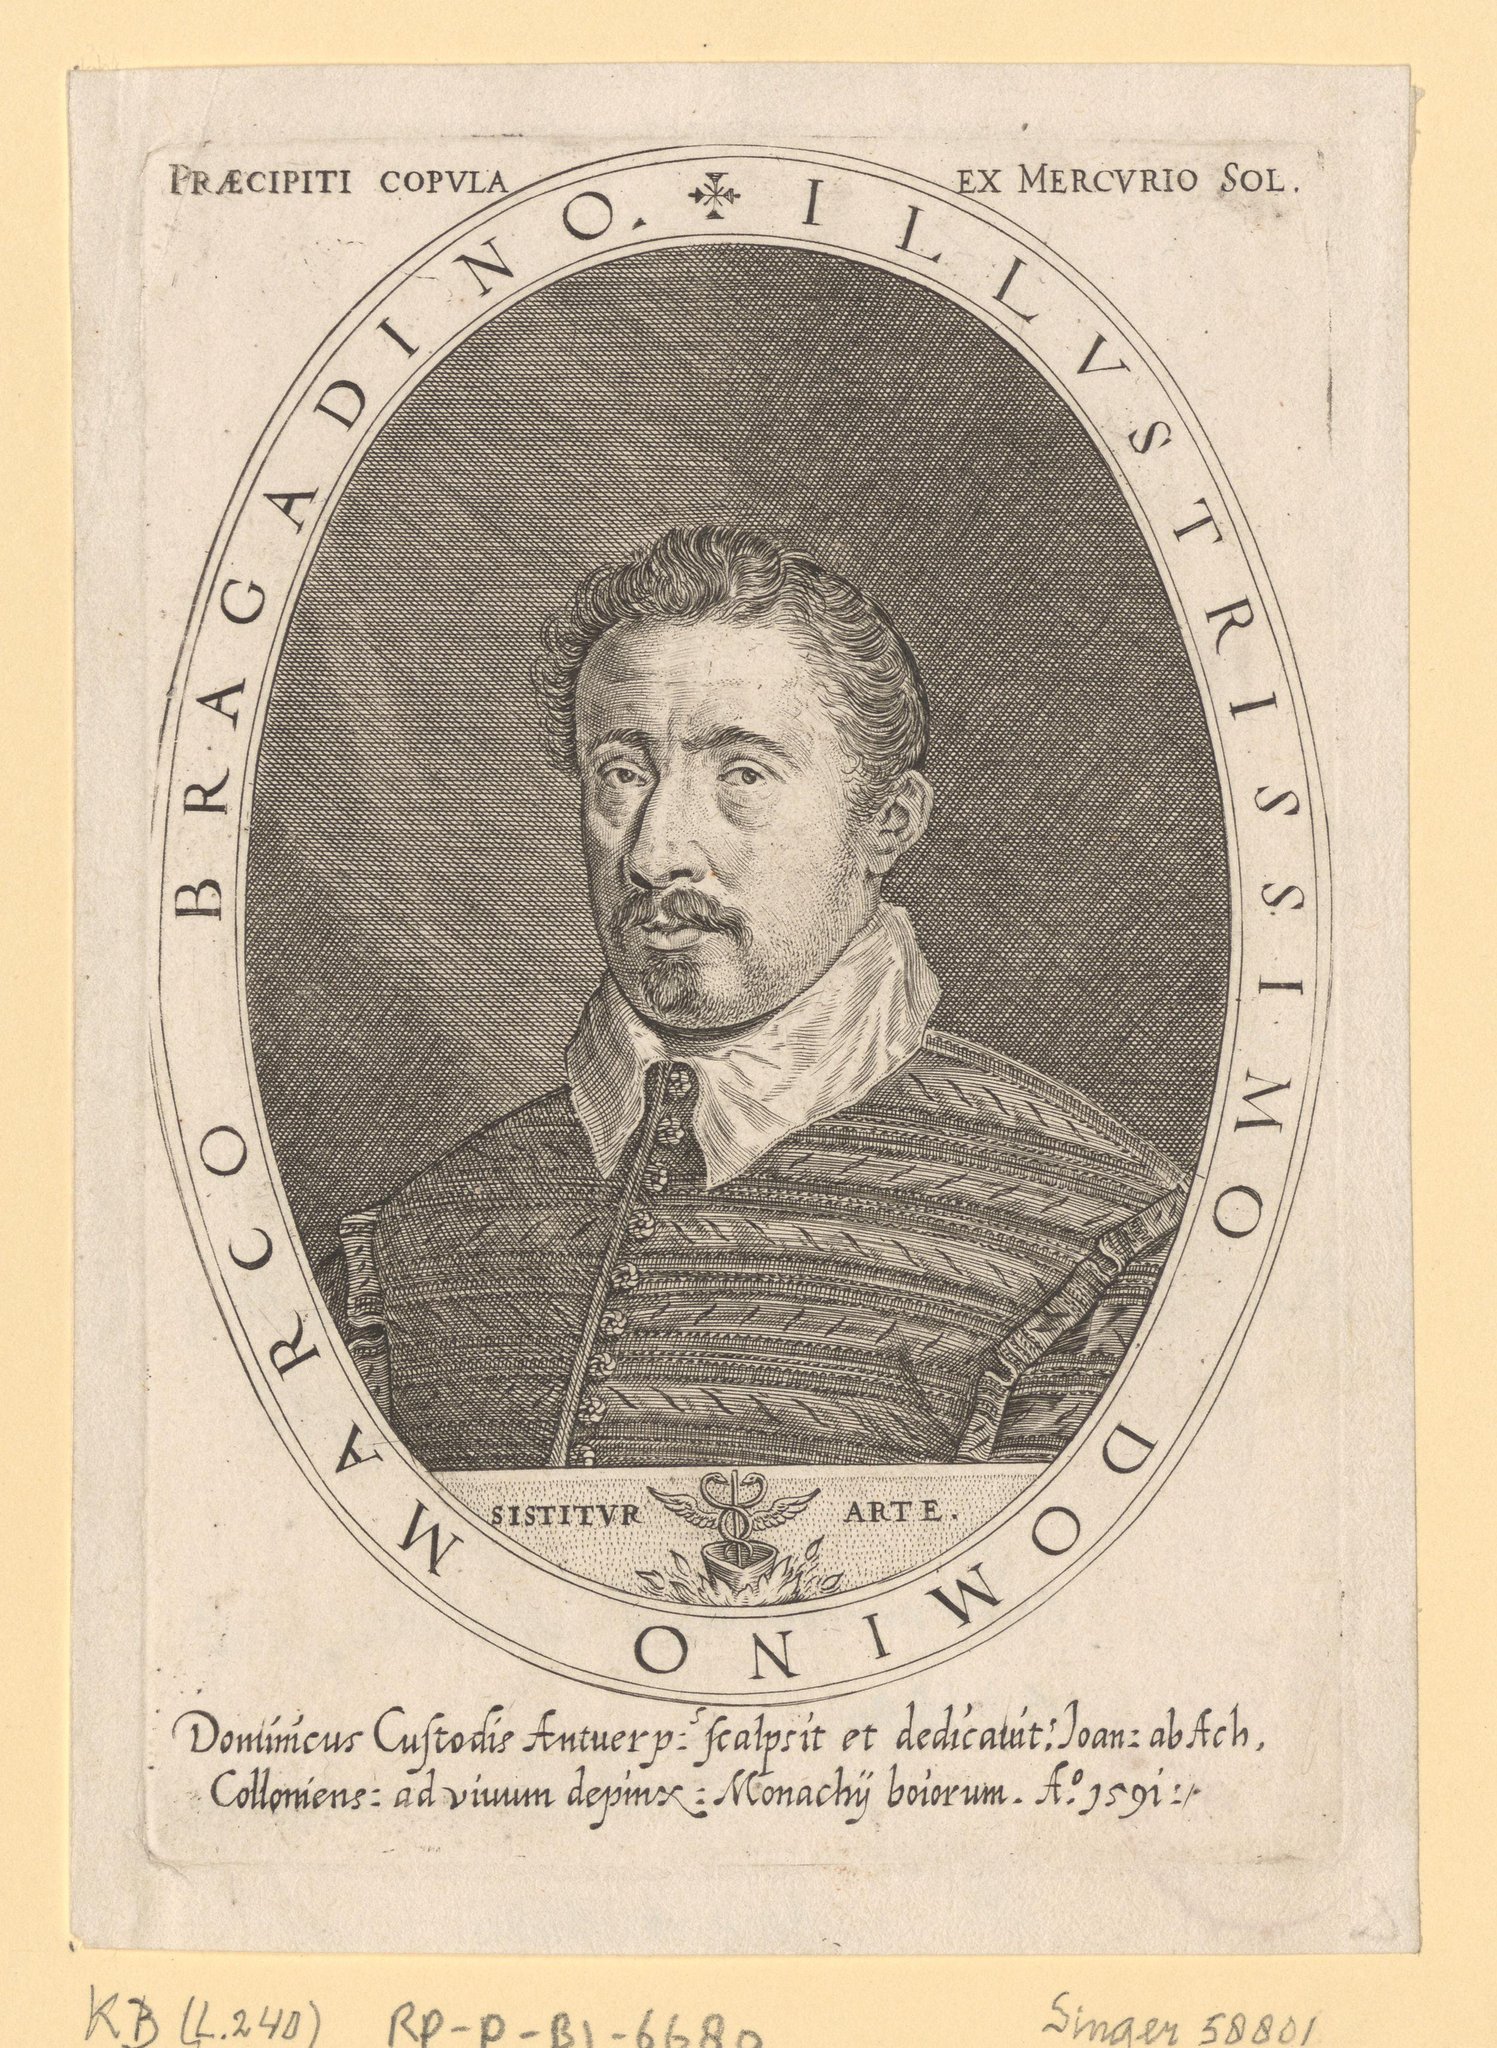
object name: print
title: Portret van Marco Bragadino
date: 1591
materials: paper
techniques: engraving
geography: antwerp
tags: ornament ~ medallion, historical persons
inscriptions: collector's mark: Lugt 240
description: Met randschrift en tweeregelig onderschrift in het Latijn.